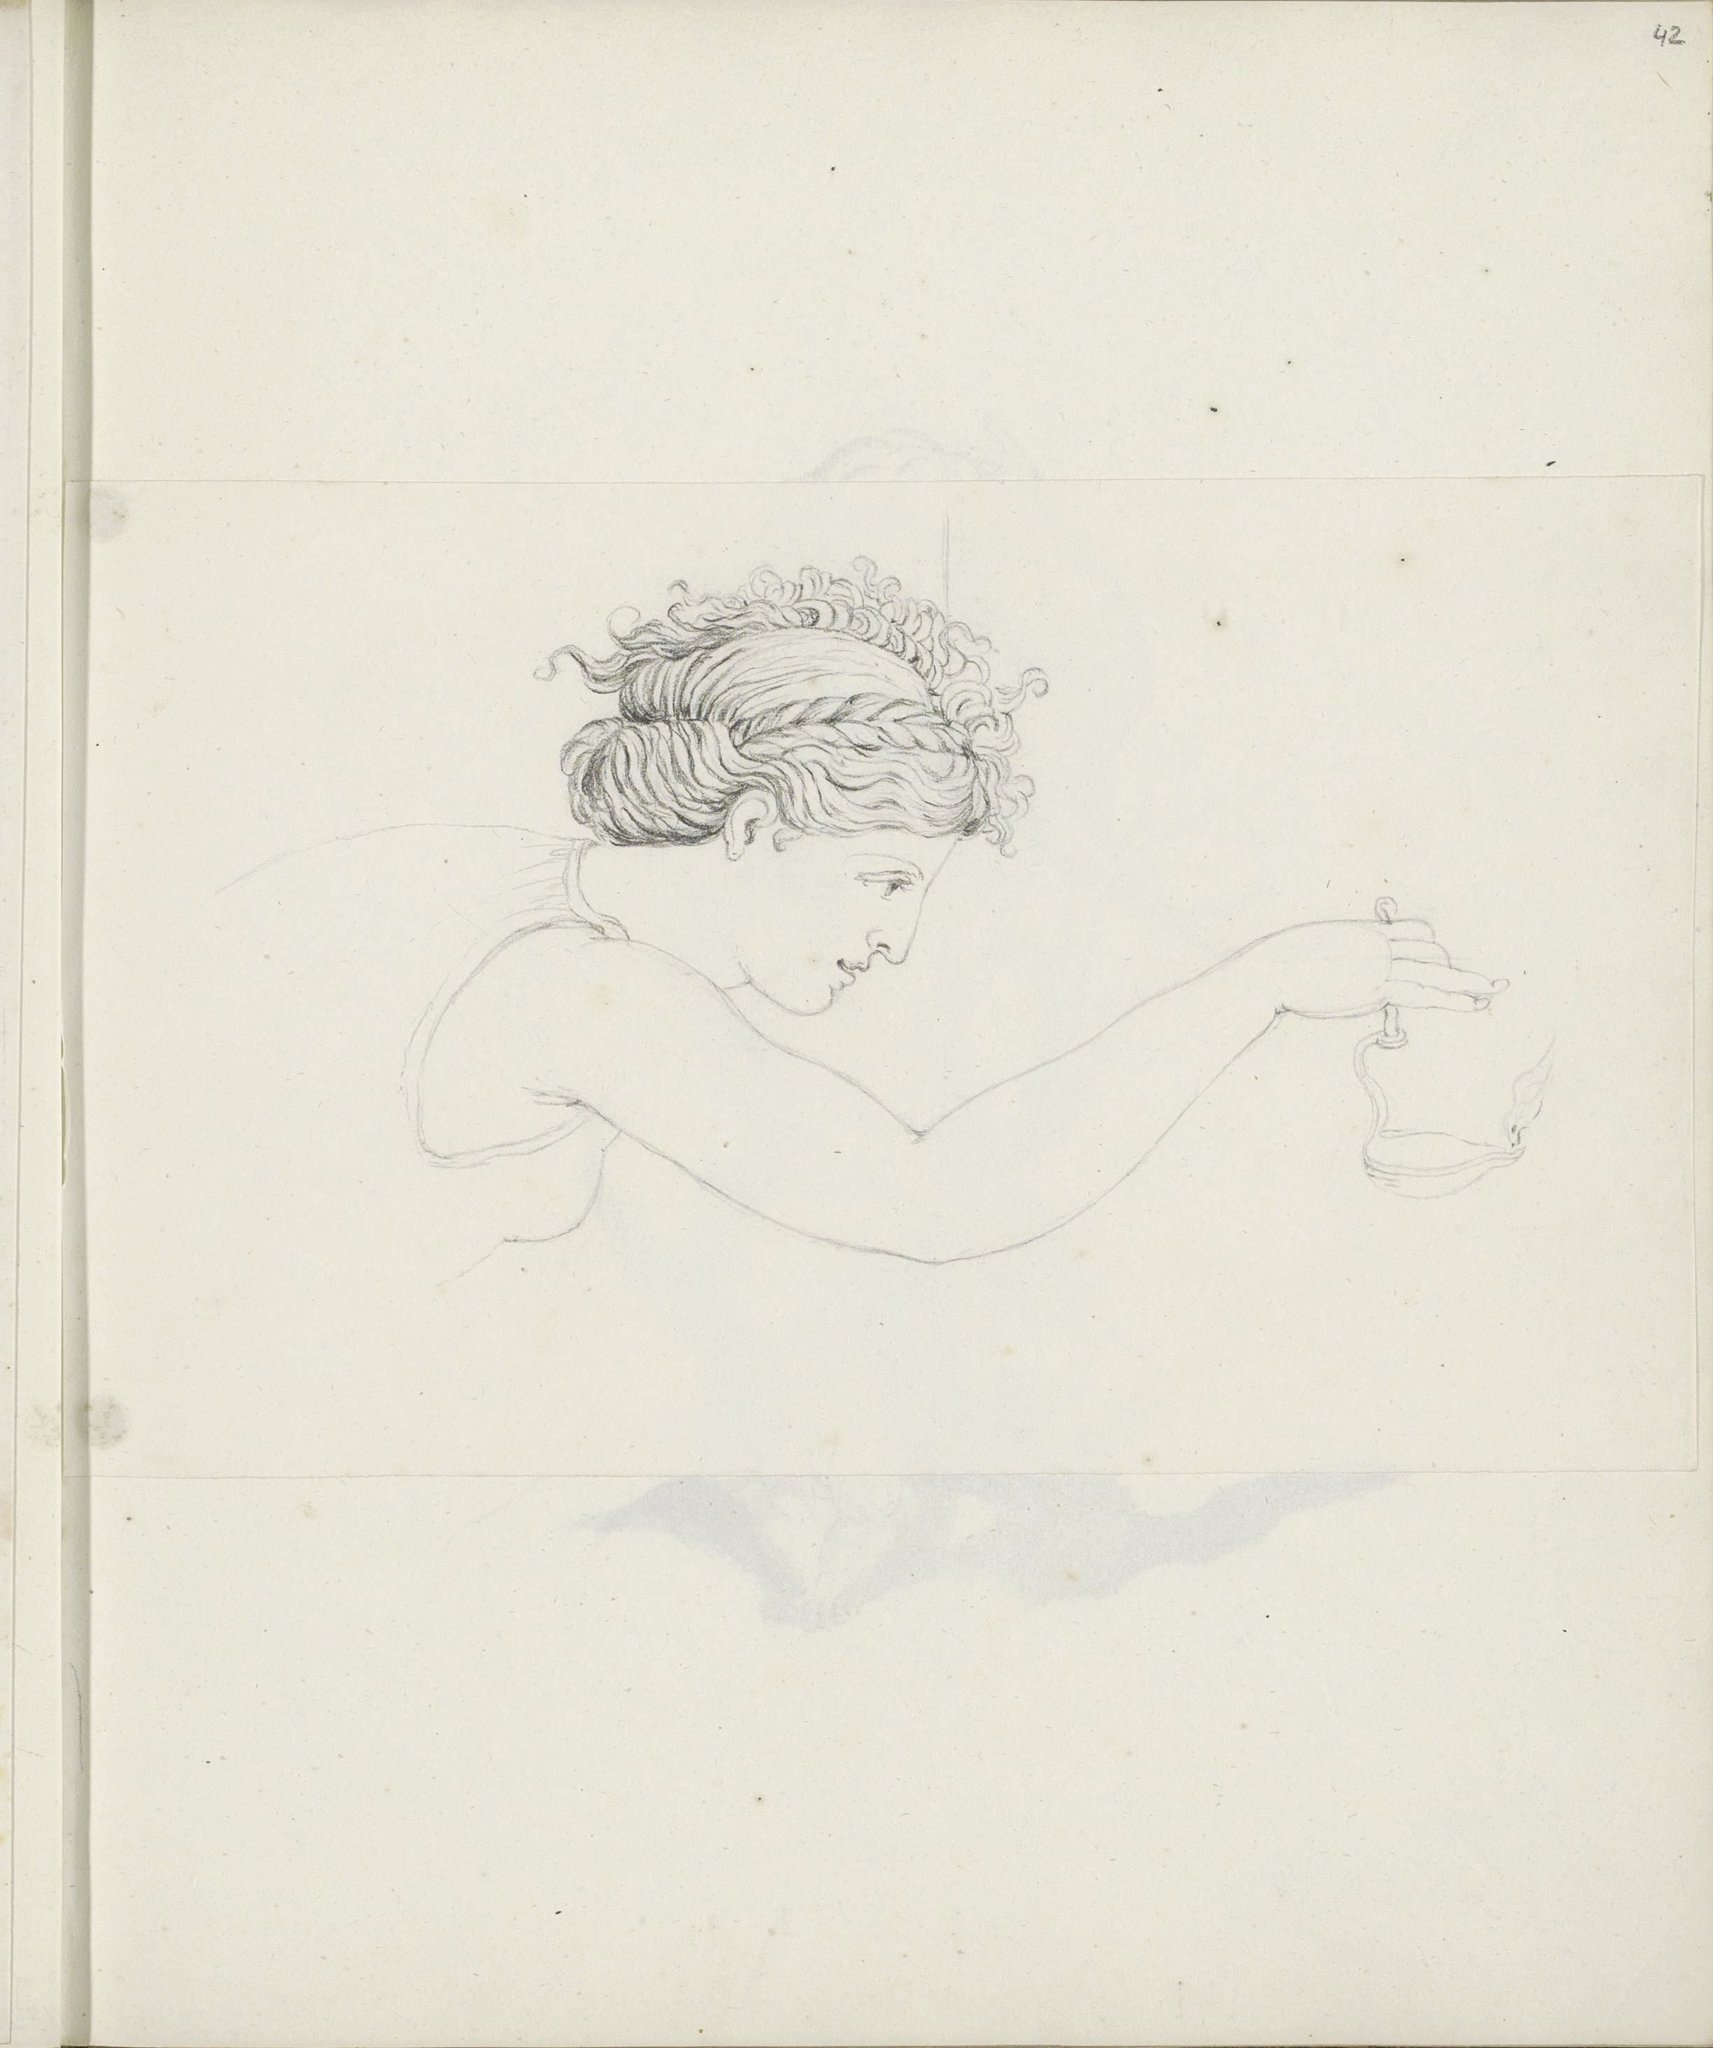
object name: sketchbook leaf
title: Vrouw met een olielamp in haar hand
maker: jonkvrouw elisabeth kemper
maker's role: draughtsman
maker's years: 1799-1871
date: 1815-1852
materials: paper, pencil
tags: female persons from classical history (+ belonging to greek history), oil-lamp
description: De vrouw heeft het haar opgestoken en buigt voorover. Vermoedelijk getekend naar klassiek voorbeeld. Ingeplakte tekening op blad 42 recto uit een schetsboek met 94 bladen.